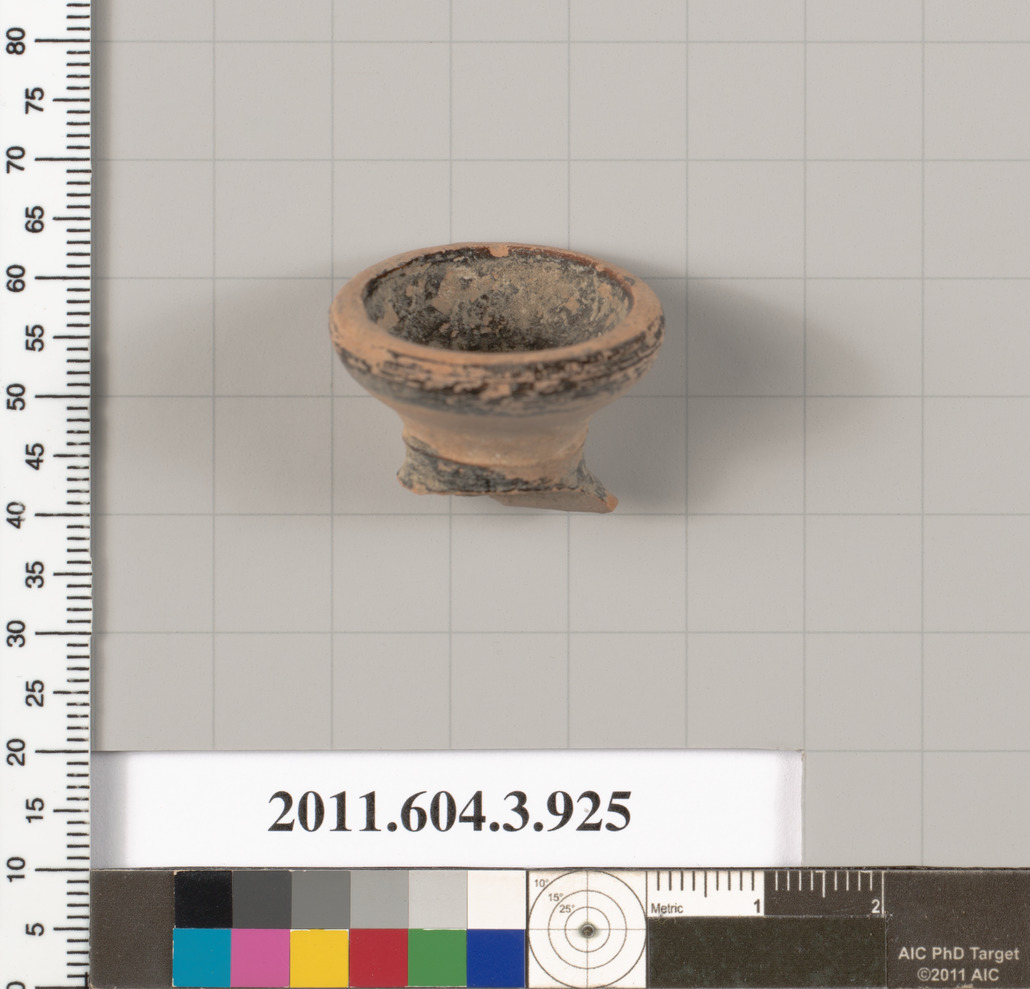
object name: lekythos fragment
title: Terracotta fragment of a lekythos (oil flask)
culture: greek, attic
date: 600-401 BCE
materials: terracotta